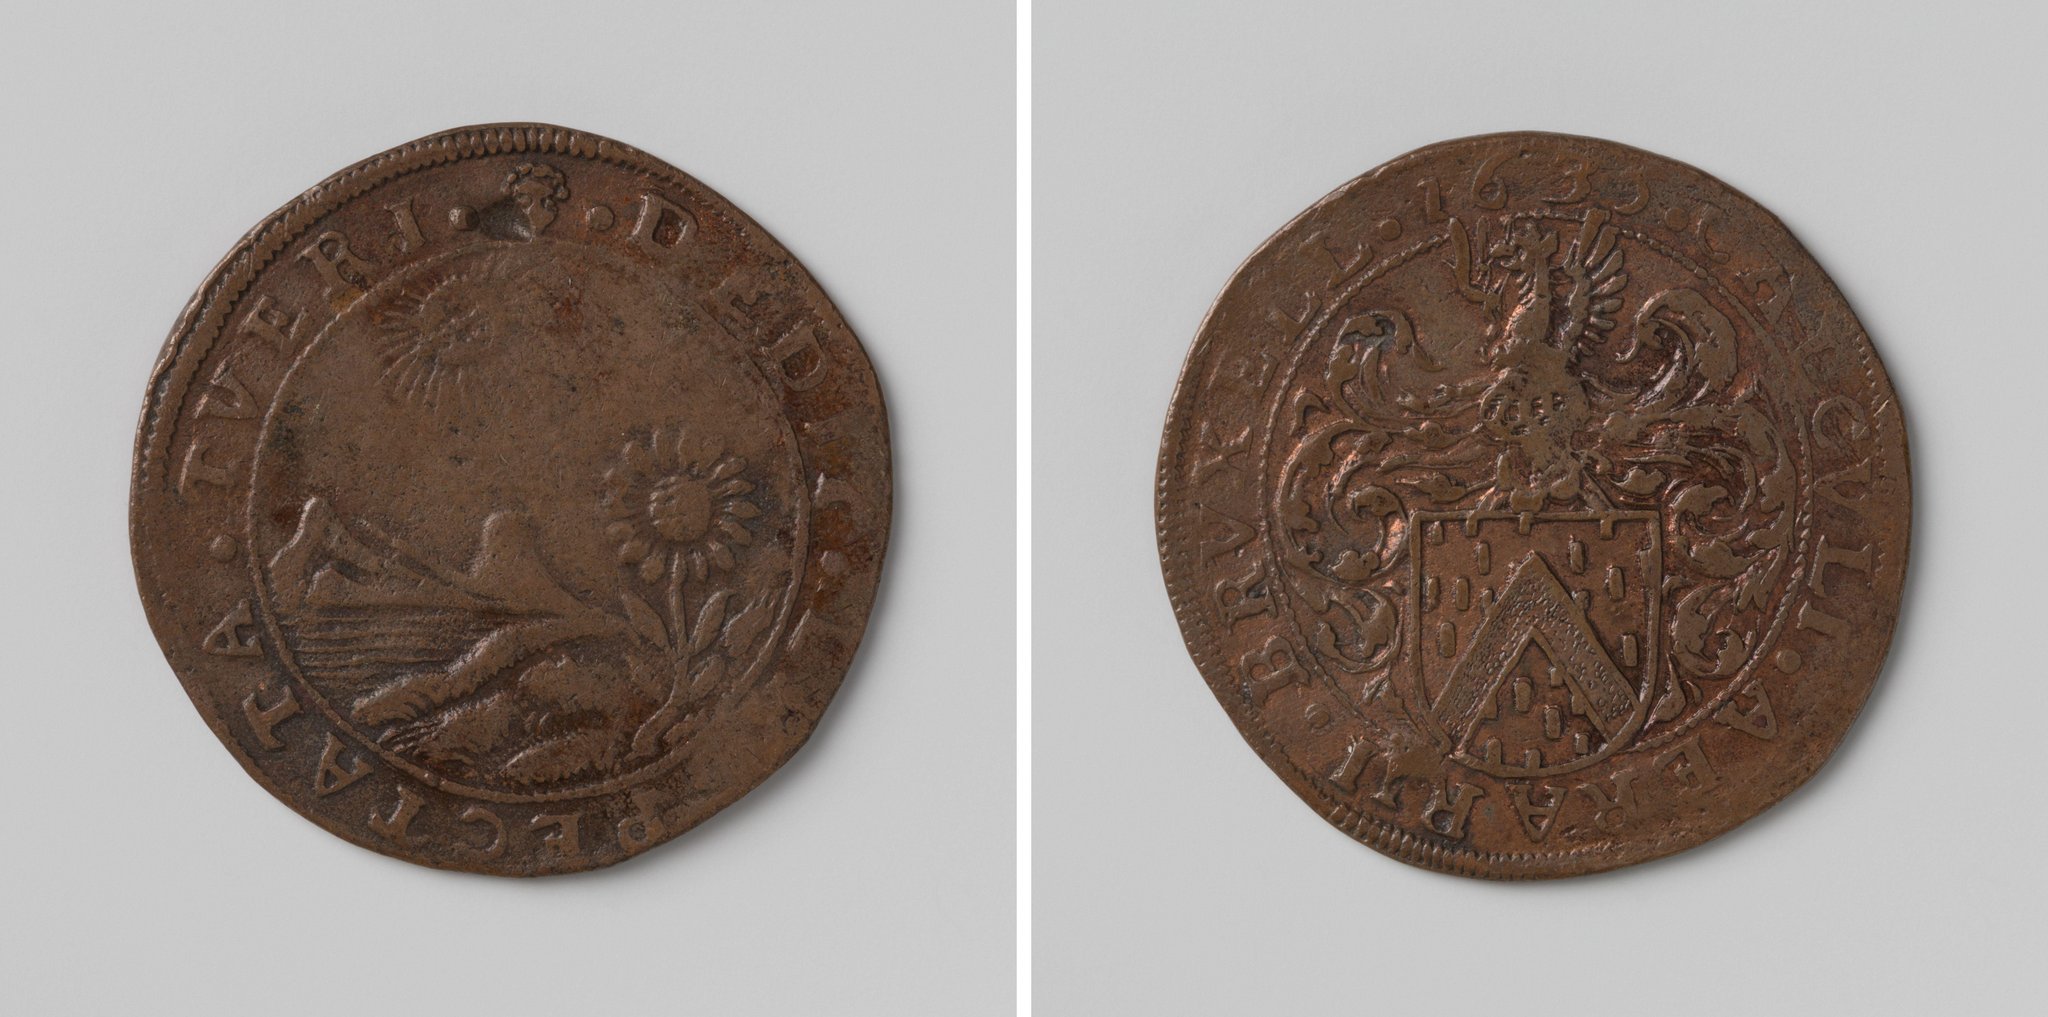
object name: jeton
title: Jean de Fourneau, magistraat van de schatkist van Brussel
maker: Anonymous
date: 1601-1635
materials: copper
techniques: striking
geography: brussels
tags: brussels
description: Koperen penning. Voorzijde: zon beschijnt geopende zonnebloem binnen omschrift. Keerzijde: gehelmd wapenschild binnen omschrift